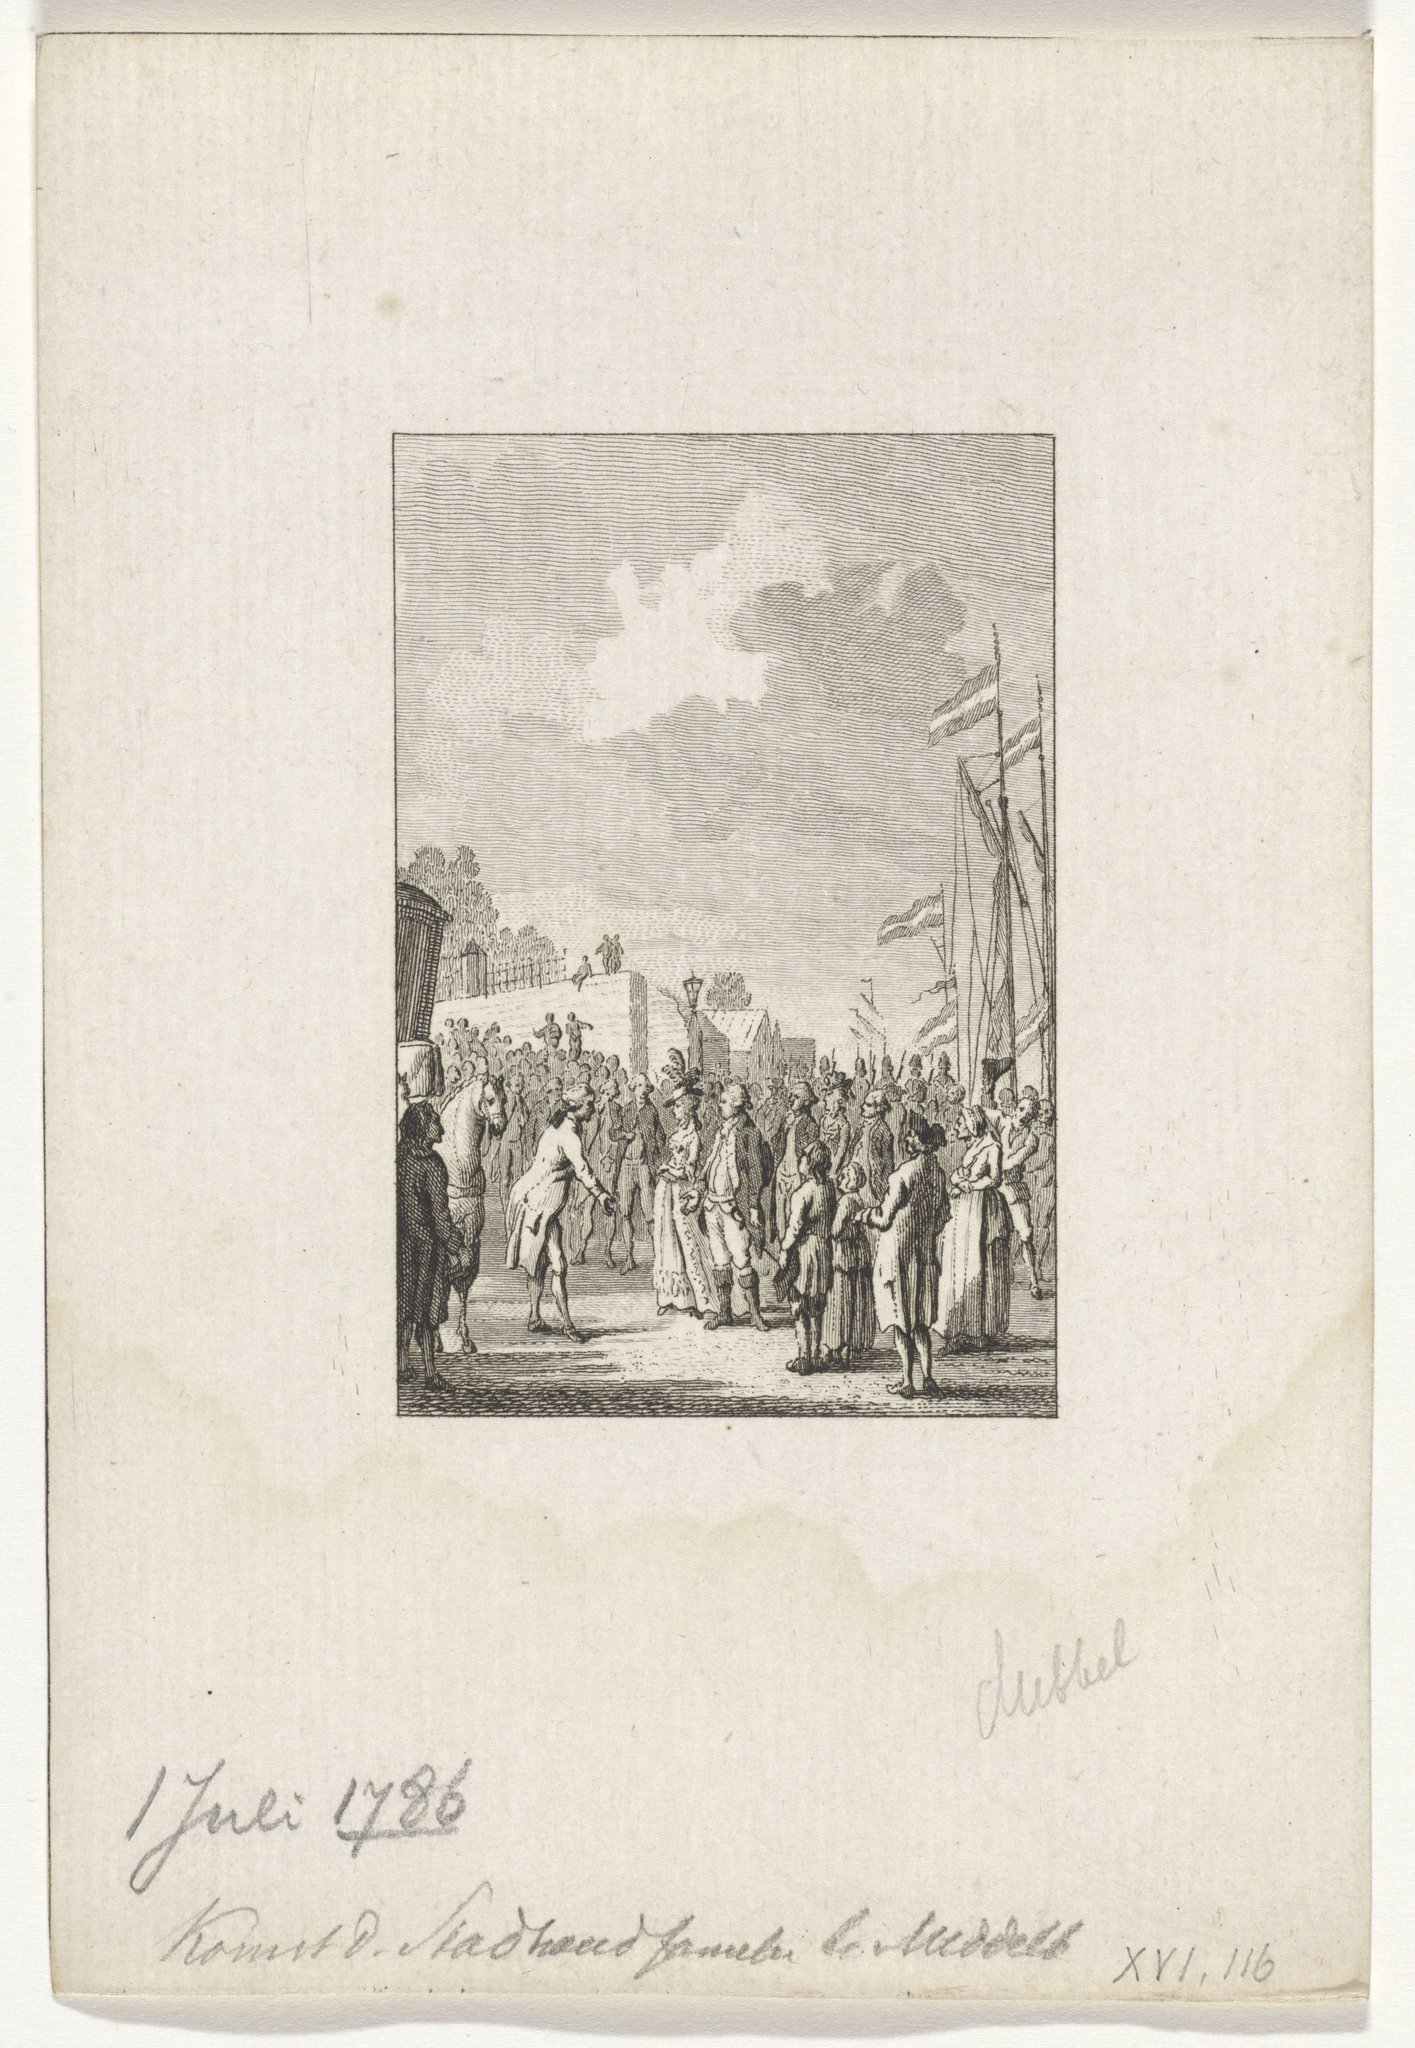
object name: print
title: Aankomst van de stadhouderlijke familie te Middelburg, 1786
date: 1783-1795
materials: paper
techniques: etching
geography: amsterdam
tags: william v (prince of orange), painter, draughtsman, wilhelmina of prussia (princess of orange), public festivities at other royal events, not meant or mentioned above, being welcomed ~ travelling, middelburg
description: Illustratie voor: J. Fokke. Geschiedenissen der Vereenigde Nederlanden voor de vaderlandsche jeugd. Amsterdam: Johannes Allart, 1783-1795, 25 delen. deel XVI pl. VIII.